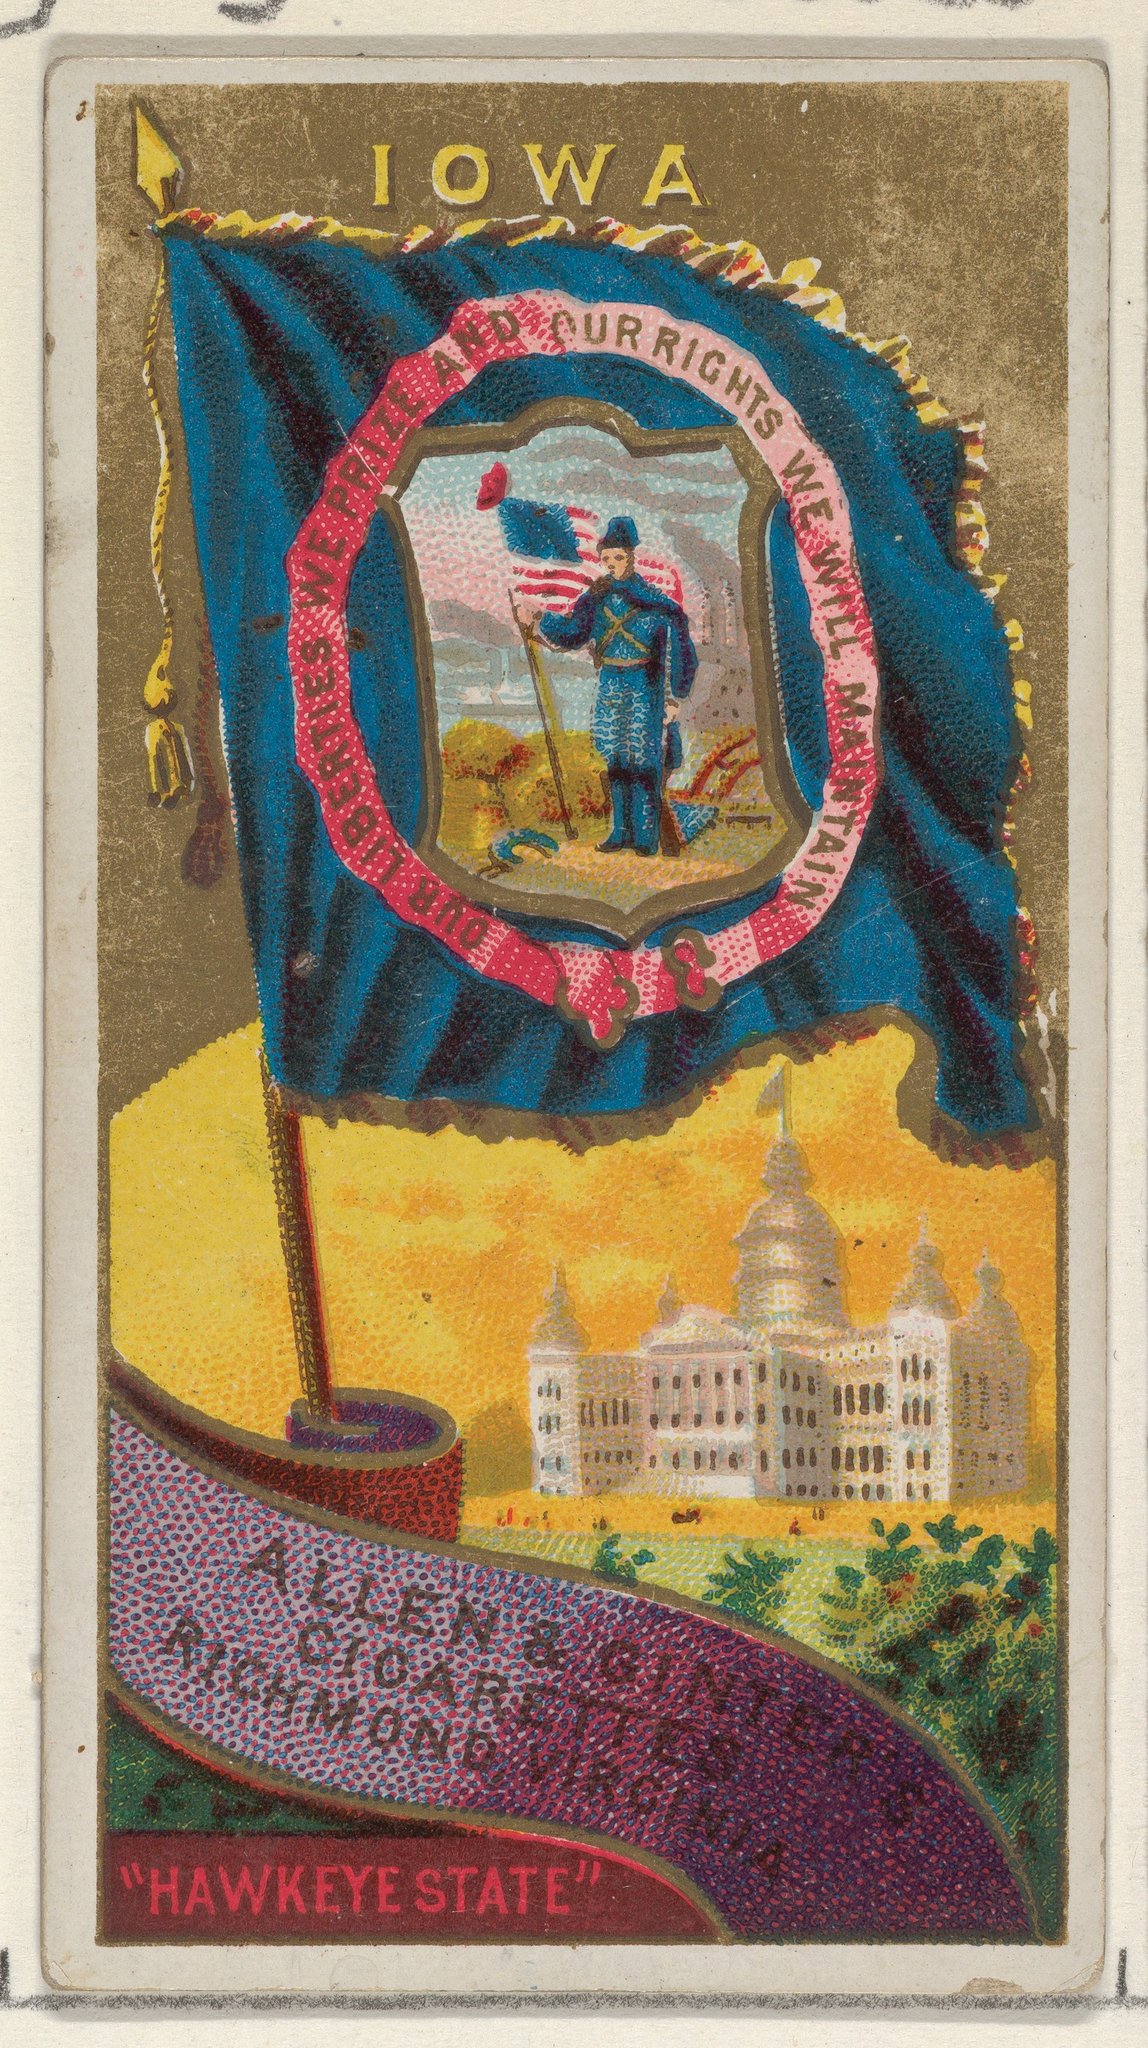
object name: print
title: Iowa, from Flags of the States and Territories (N11) for Allen & Ginter Cigarettes Brands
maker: allen & ginter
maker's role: publisher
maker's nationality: american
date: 1888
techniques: color lithograph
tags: flags